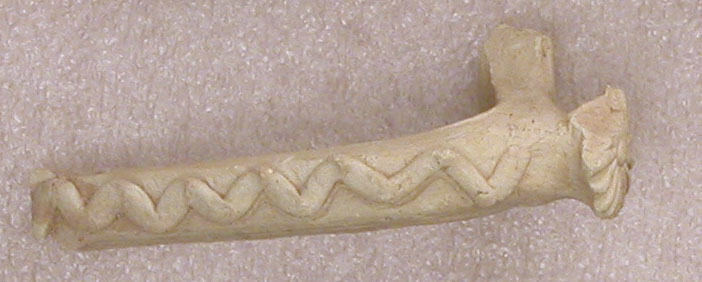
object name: handle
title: Fragment of a Handle with Wavy Band and Rosette-Shaped Thumb Rest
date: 801-1100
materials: earthenware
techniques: molding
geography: iraq